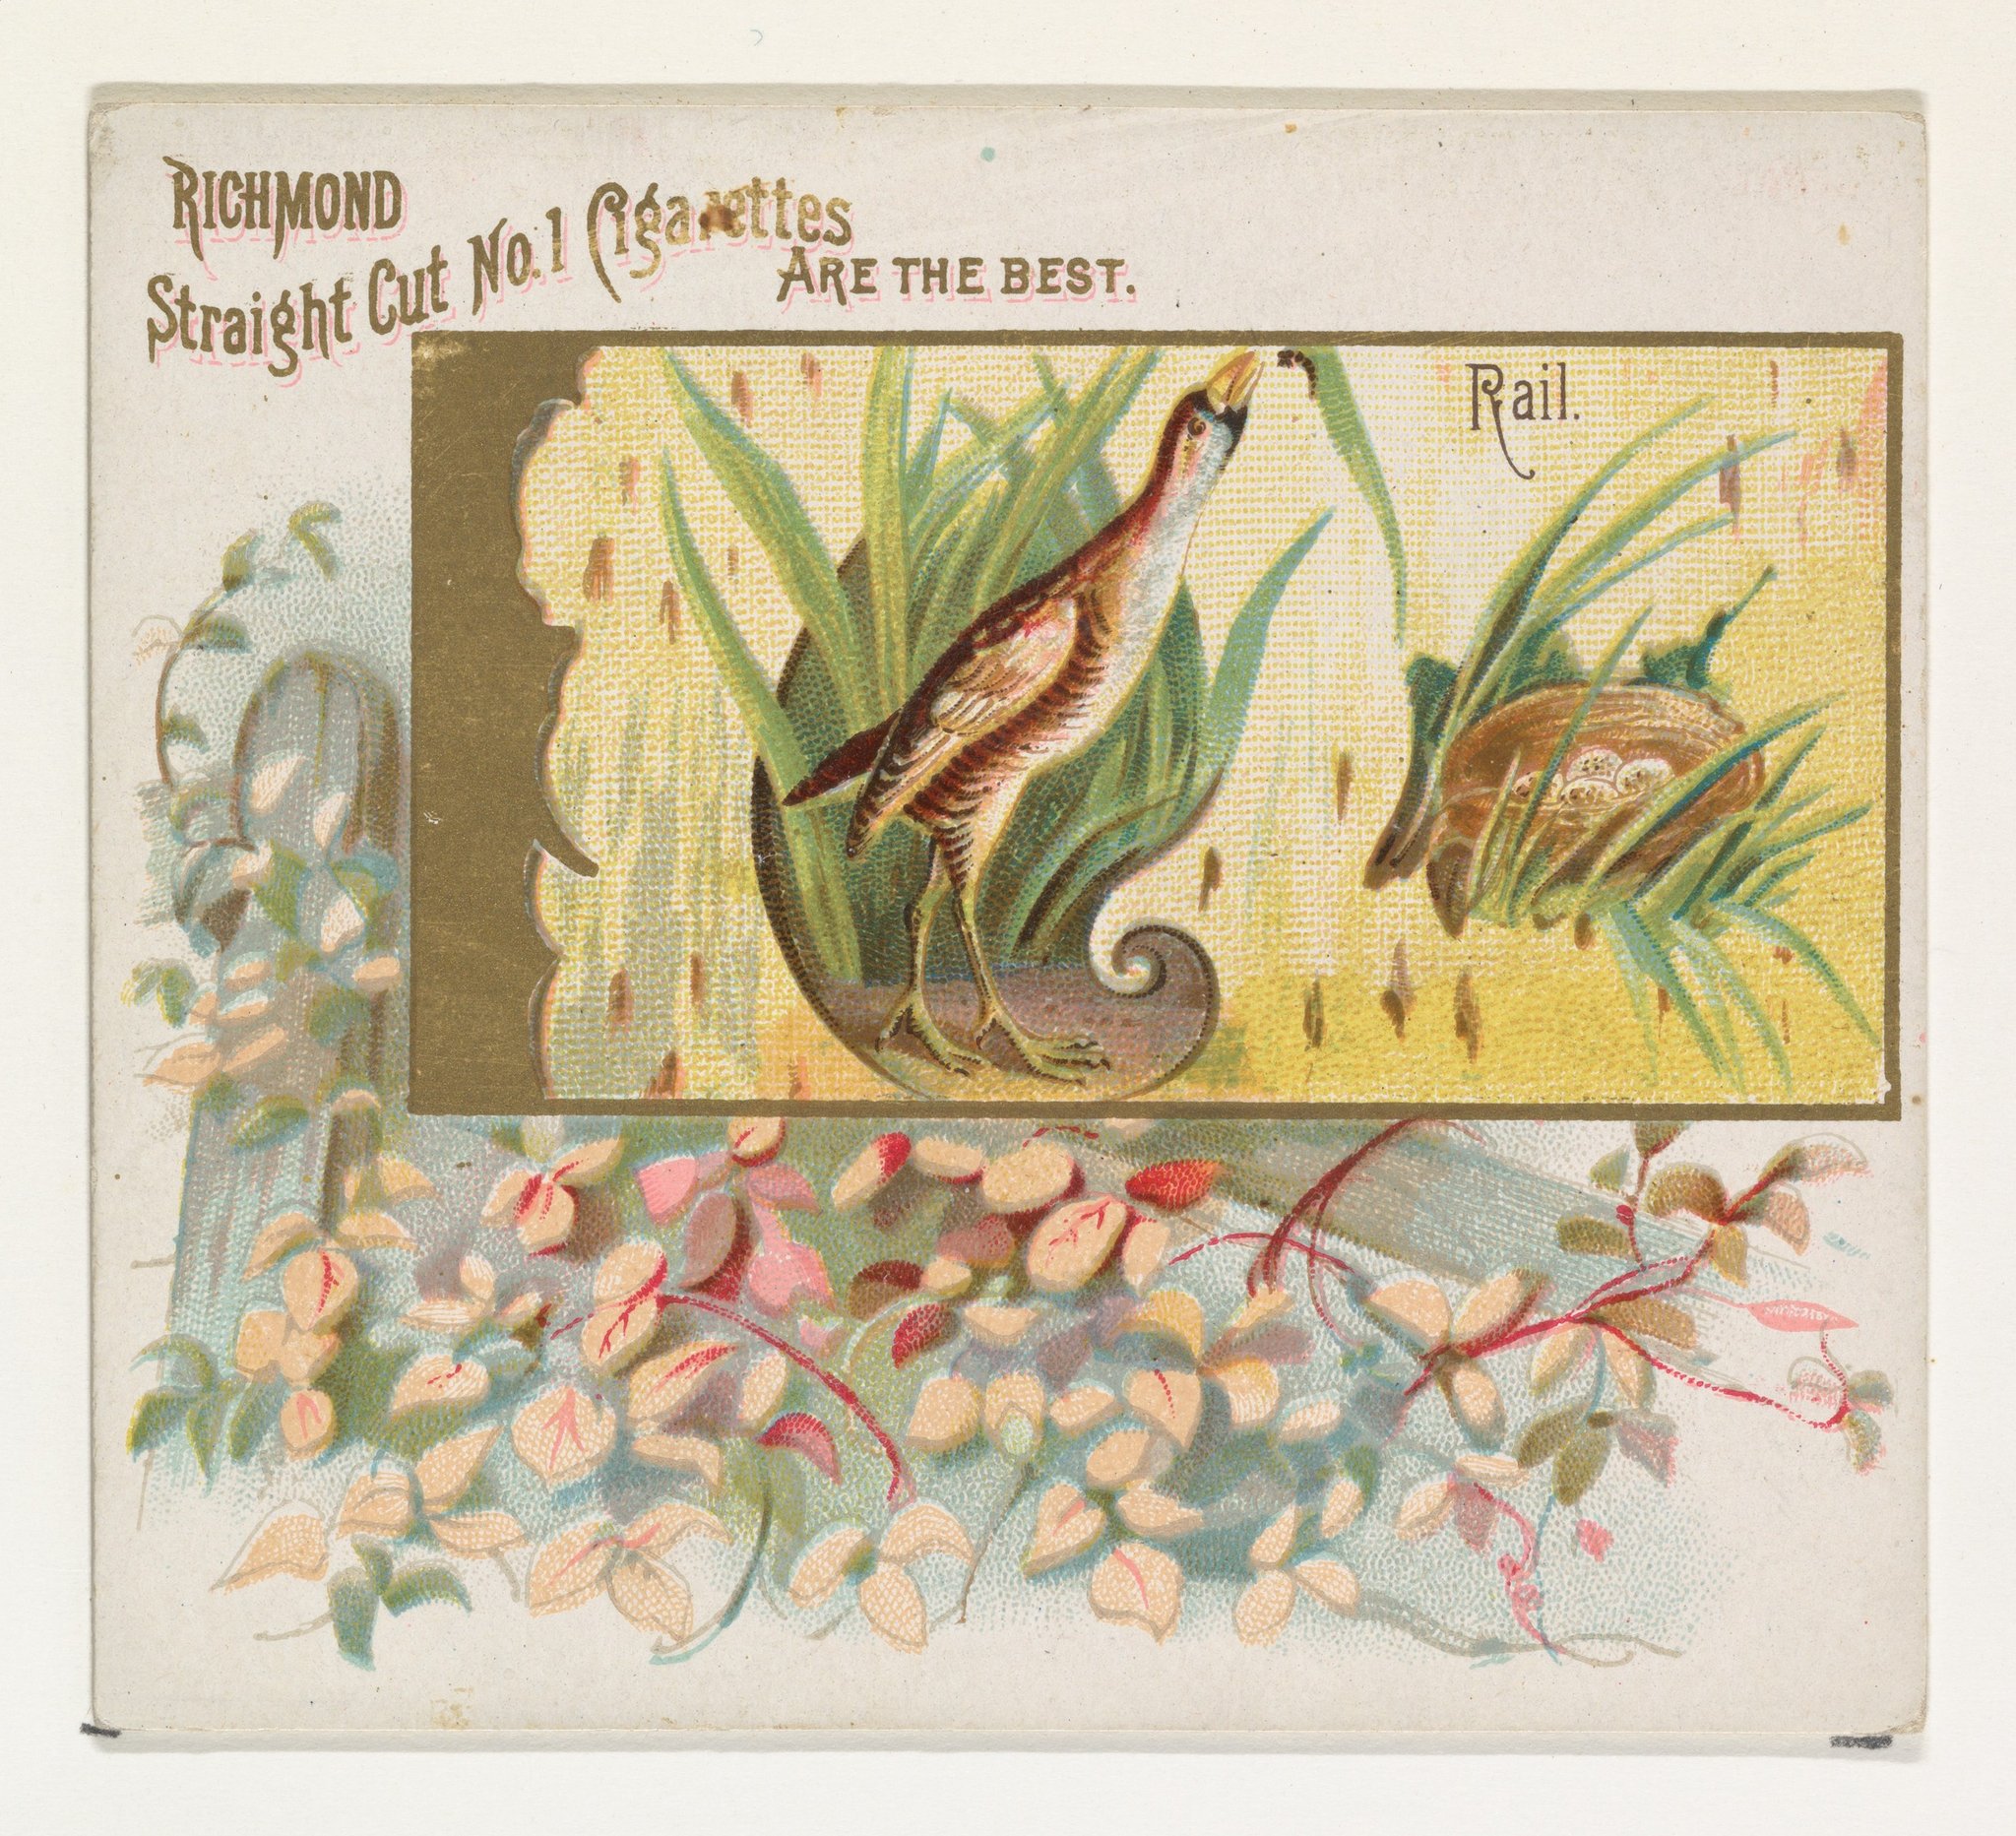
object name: print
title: Rail, from the Game Birds series (N40) for Allen & Ginter Cigarettes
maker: allen & ginter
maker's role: publisher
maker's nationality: american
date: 1888-1890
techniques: color lithograph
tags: birds